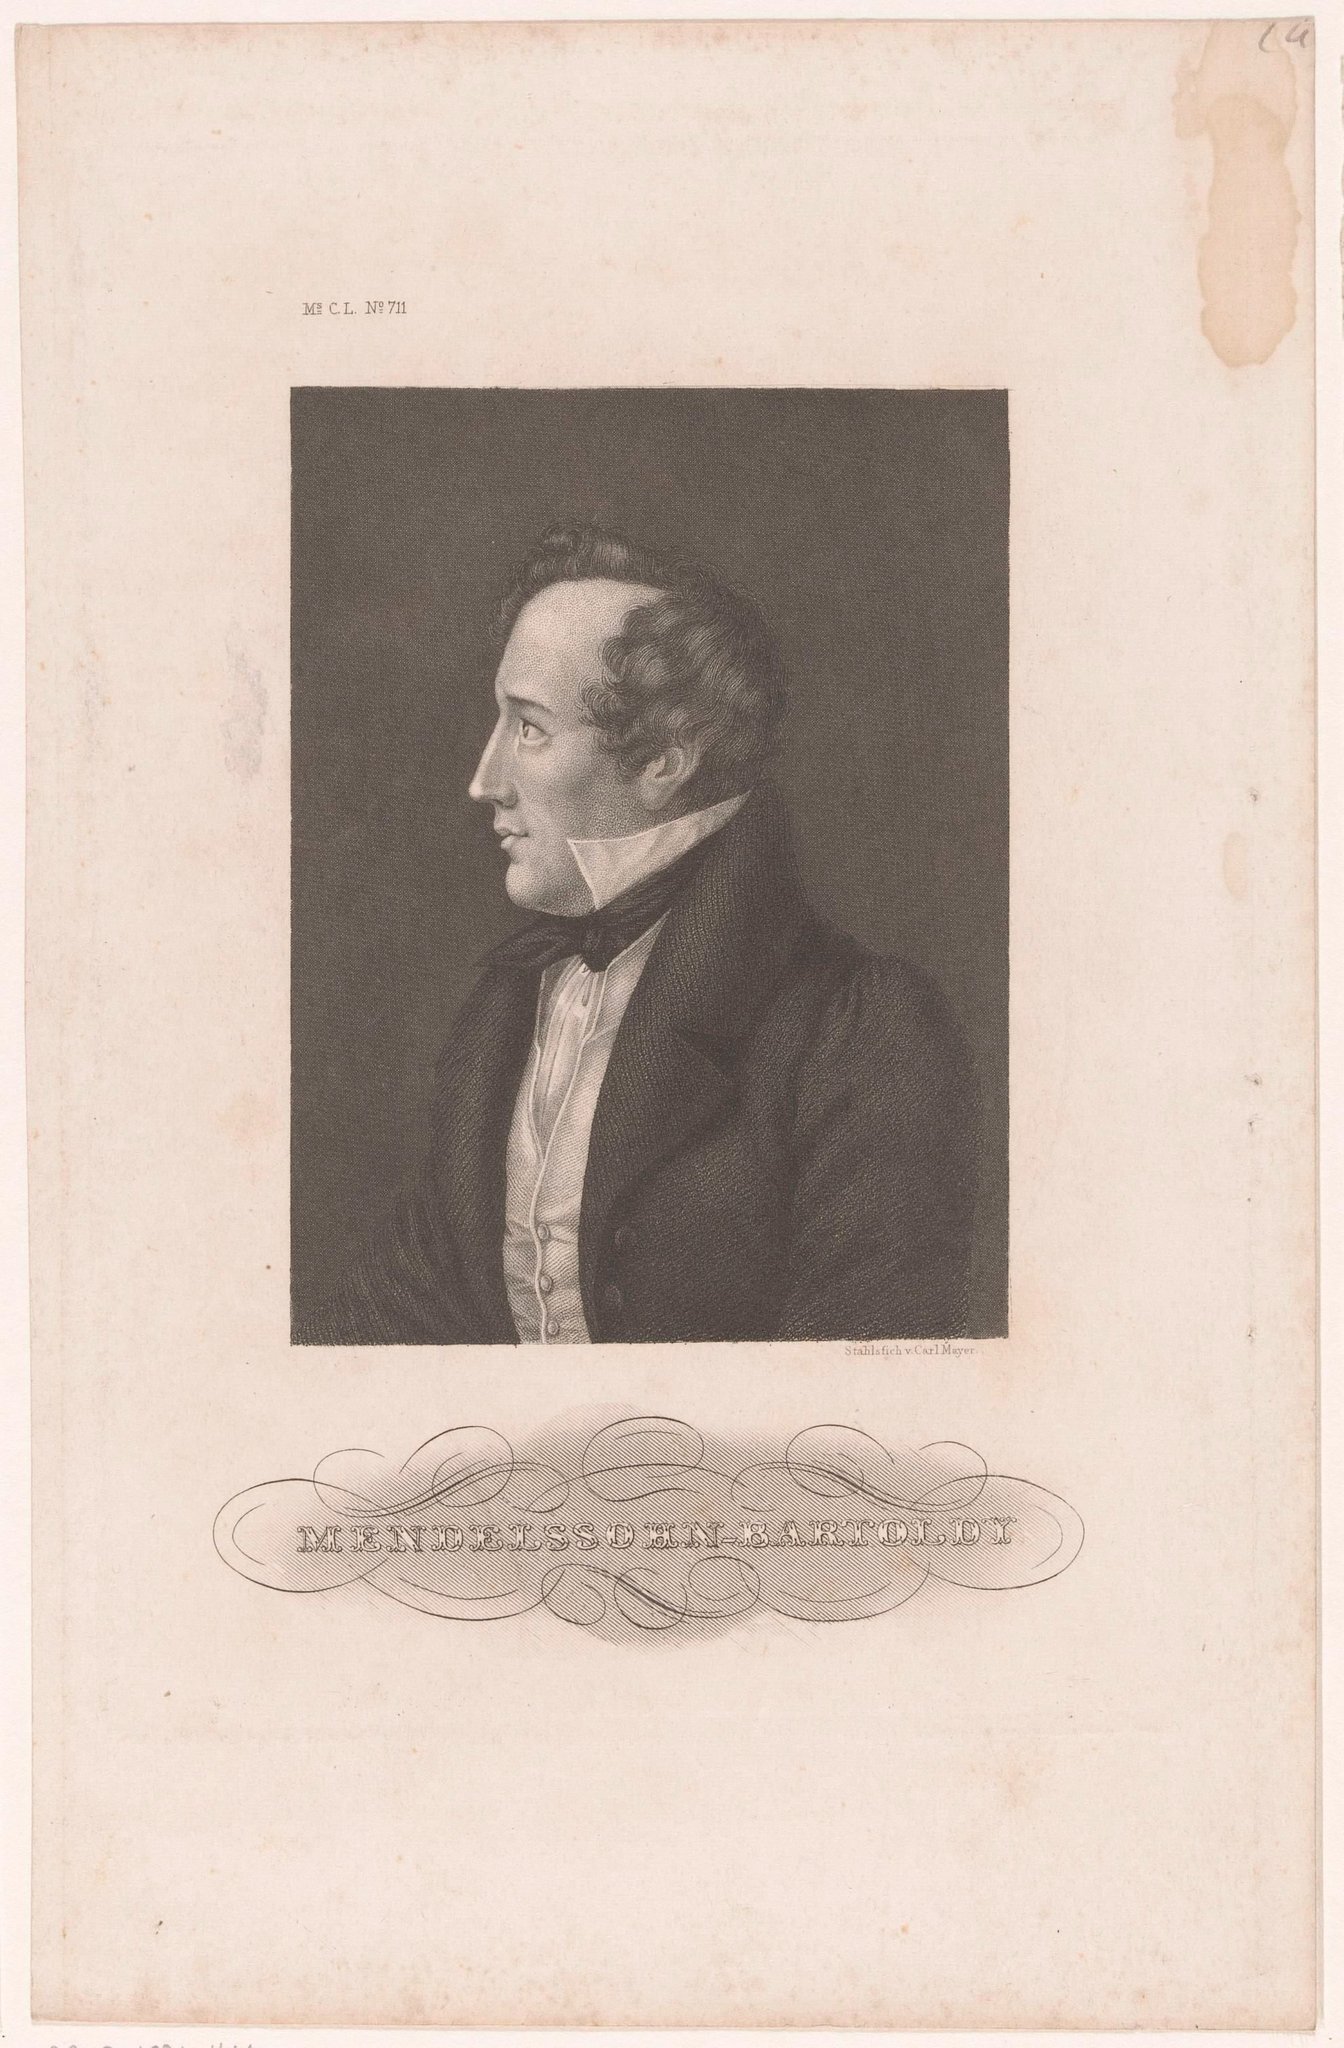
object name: print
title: Portret van Felix Mendelssohn Bartholdy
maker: carl mayer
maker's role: print maker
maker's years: 1798-1868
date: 1840-1855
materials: paper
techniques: engraving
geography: hildburghausen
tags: historical persons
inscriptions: collector's mark: Lugt 2233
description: Prent afkomstig uit: Conversations-Lexikon für die gebildeten Stände, voor het eerst uitgegeven tussen 1840-1855.